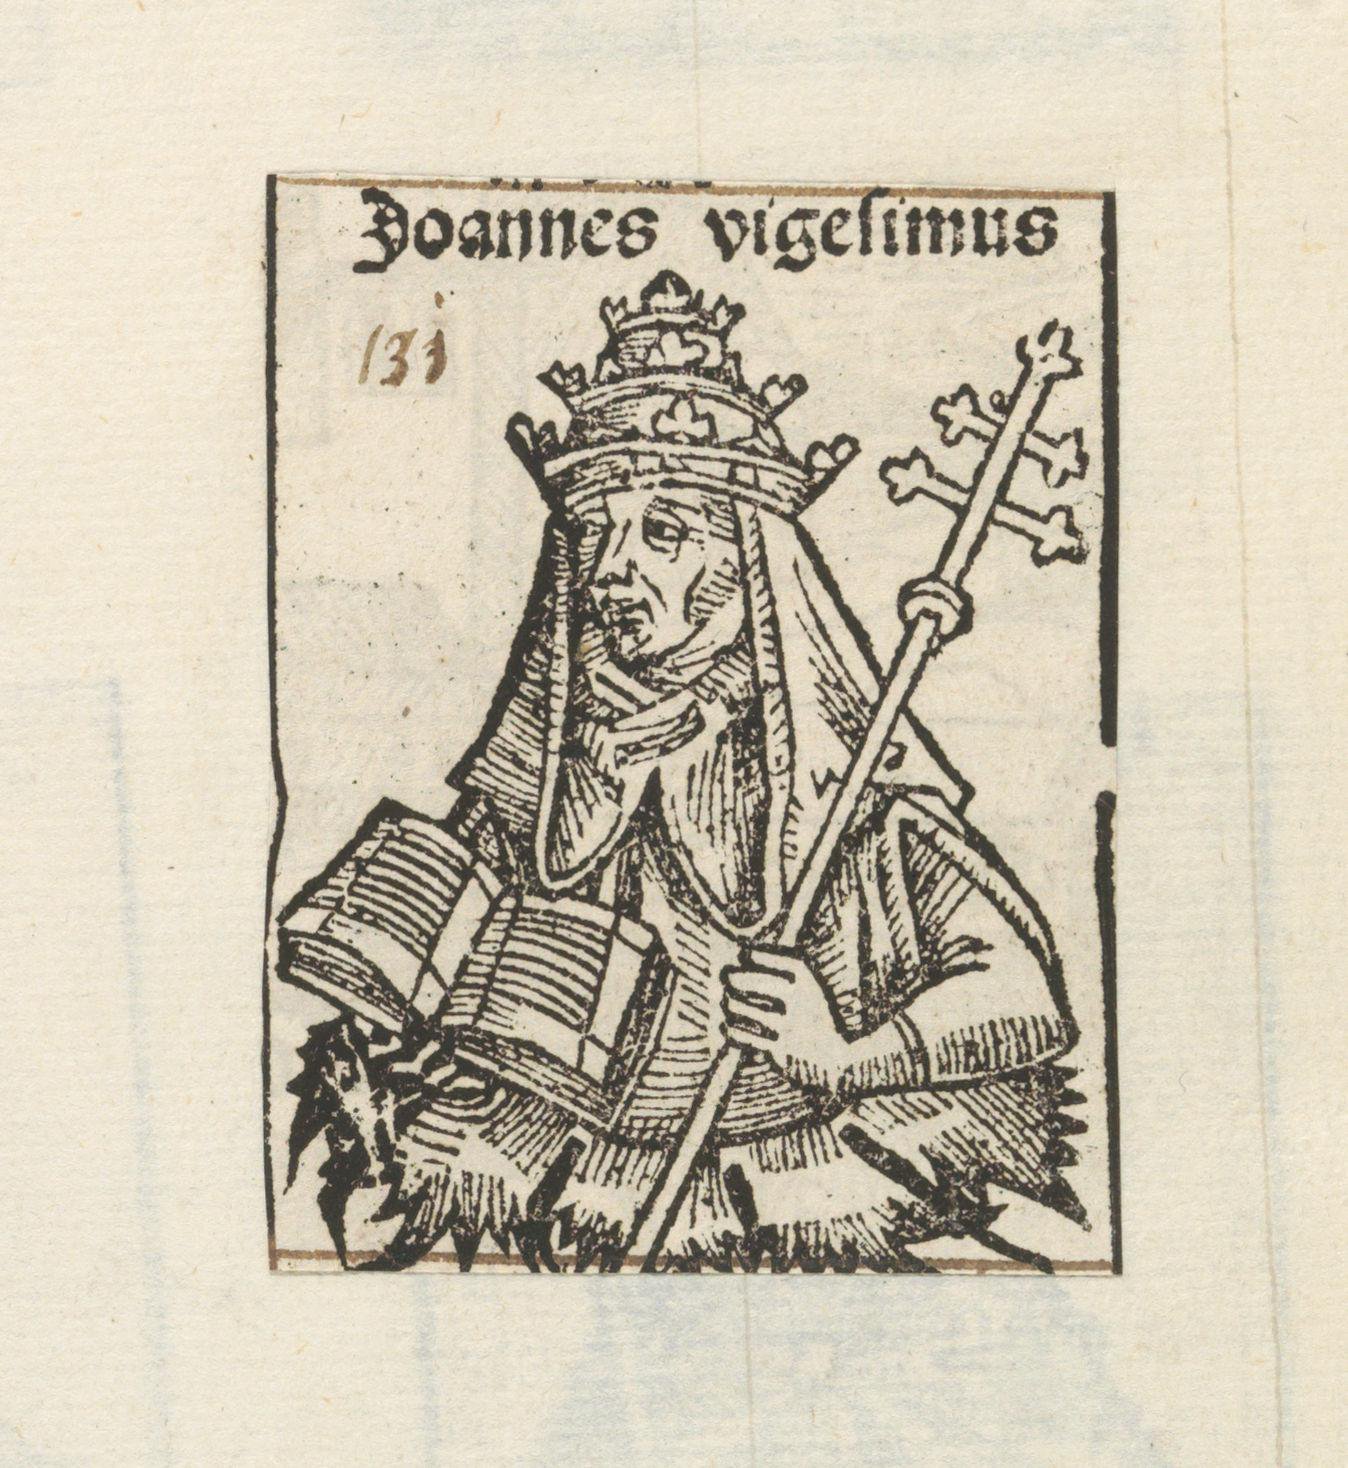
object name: print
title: Paus Johannes XIX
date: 1493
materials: paper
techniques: letterpress printing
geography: nuremberg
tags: rome, pope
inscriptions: inscription: ‘131’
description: Een bloemkelk met een paus. Hij draagt een tiara en heeft een opengeslagen bijbel en een staf met dubbel kruis in zijn handen. De voorstelling is onderdeel van de opeenvolging pausen in de Liber Chronicarum. De tekst noemt de man Johannes XX, bedoeld wordt Johannes XIX. De prent maakt deel uit van een album.